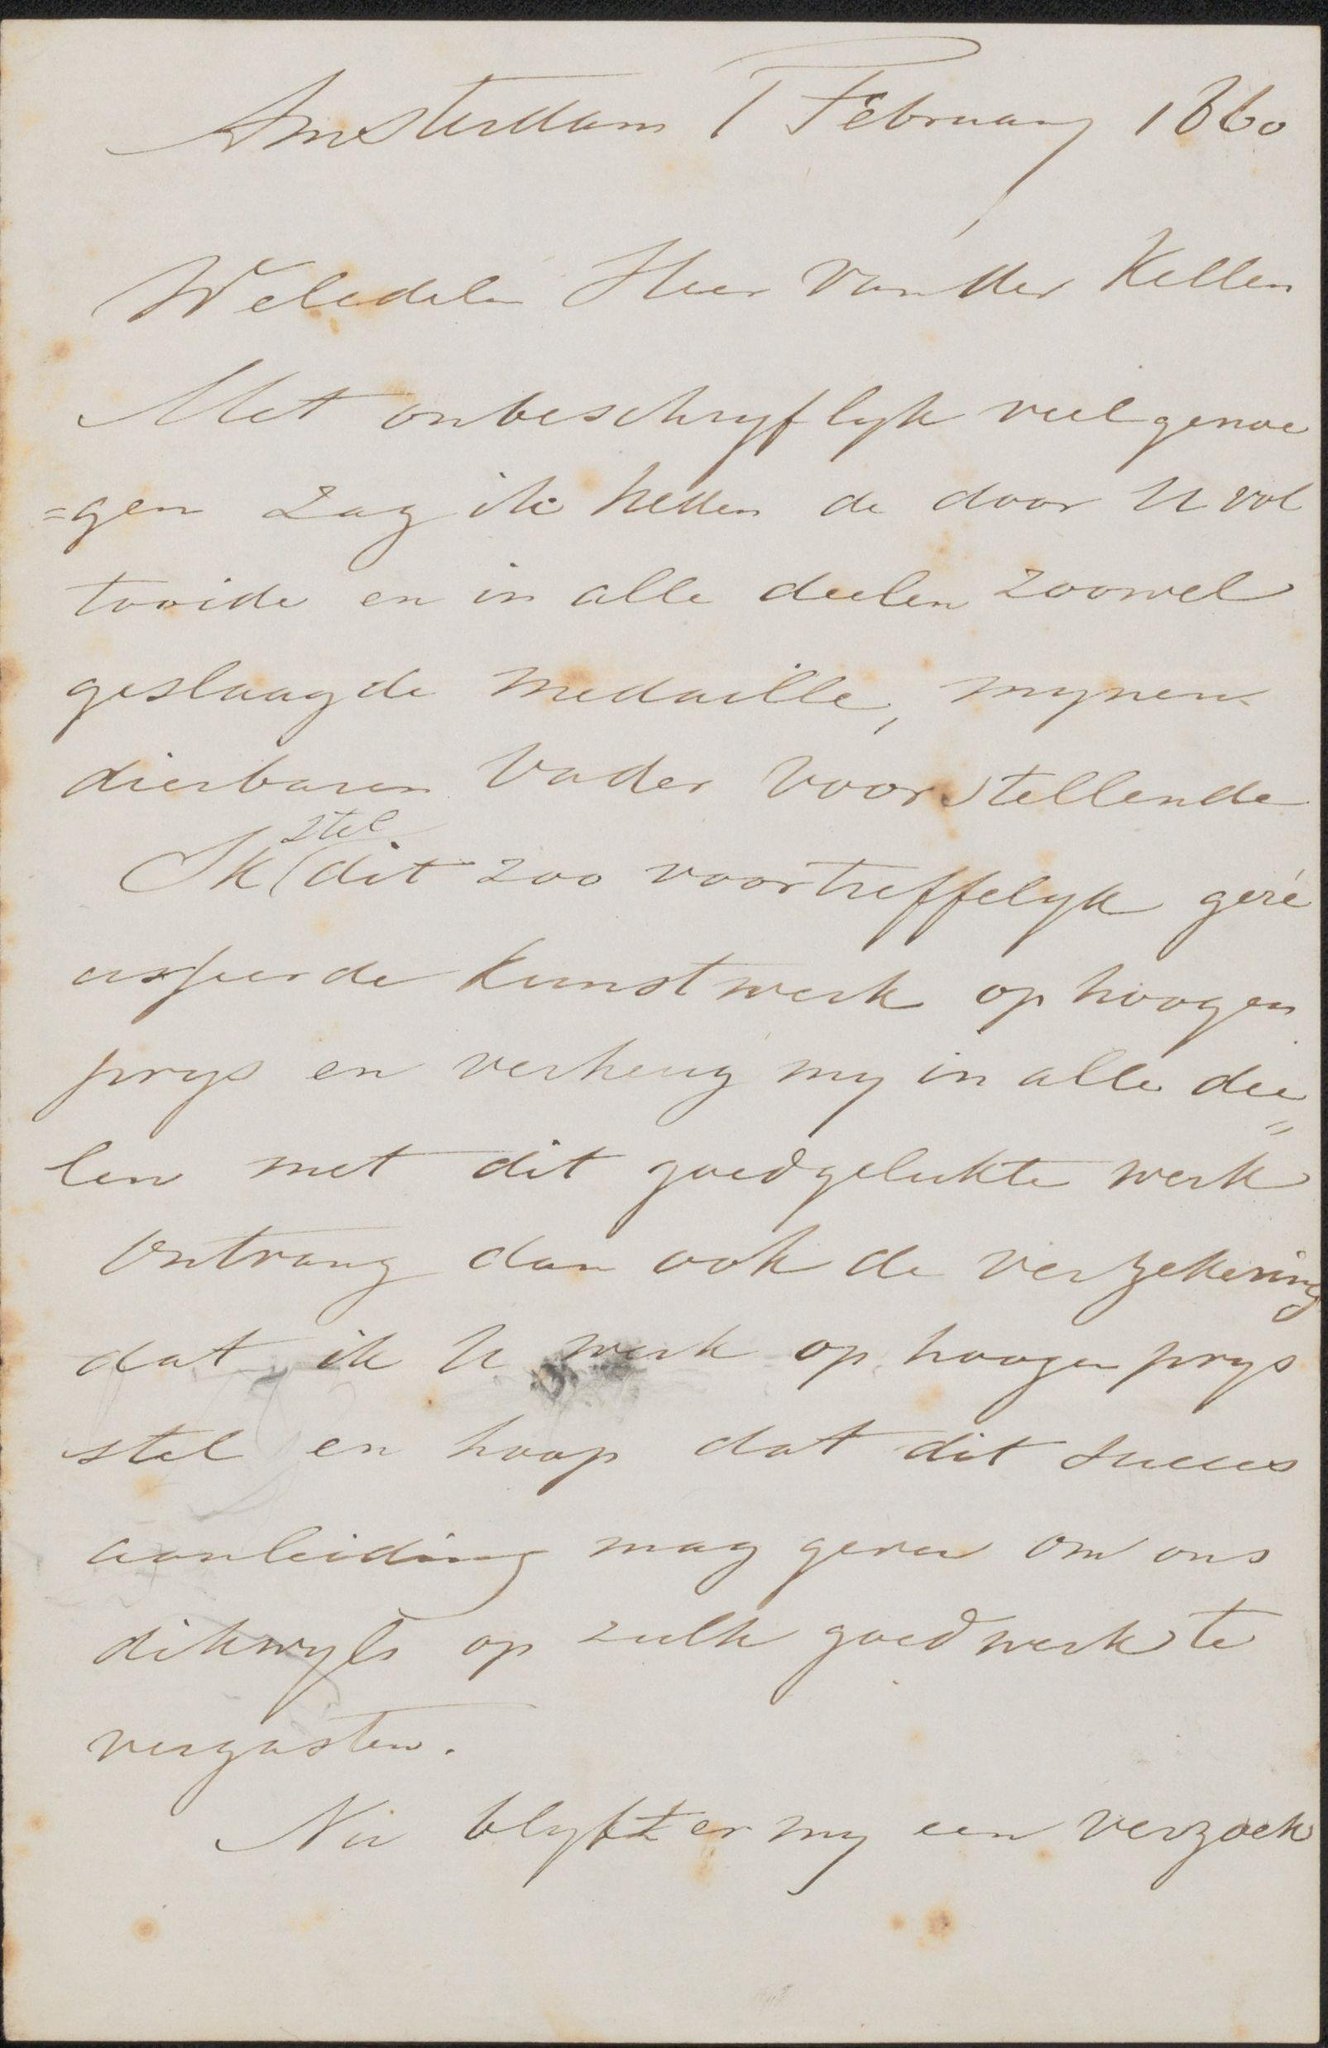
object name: letter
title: Brief aan Johan Philip van der Kellen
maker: nicolaas pieneman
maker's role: draughtsman, painter, print maker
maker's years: 1809-1860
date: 1860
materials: ink, paper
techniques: pen, writing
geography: amsterdam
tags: abcoude, amsterdam, painter, jan willem pieneman, utrecht, print maker, draughtsman, johan philip van der kellen, sculpture